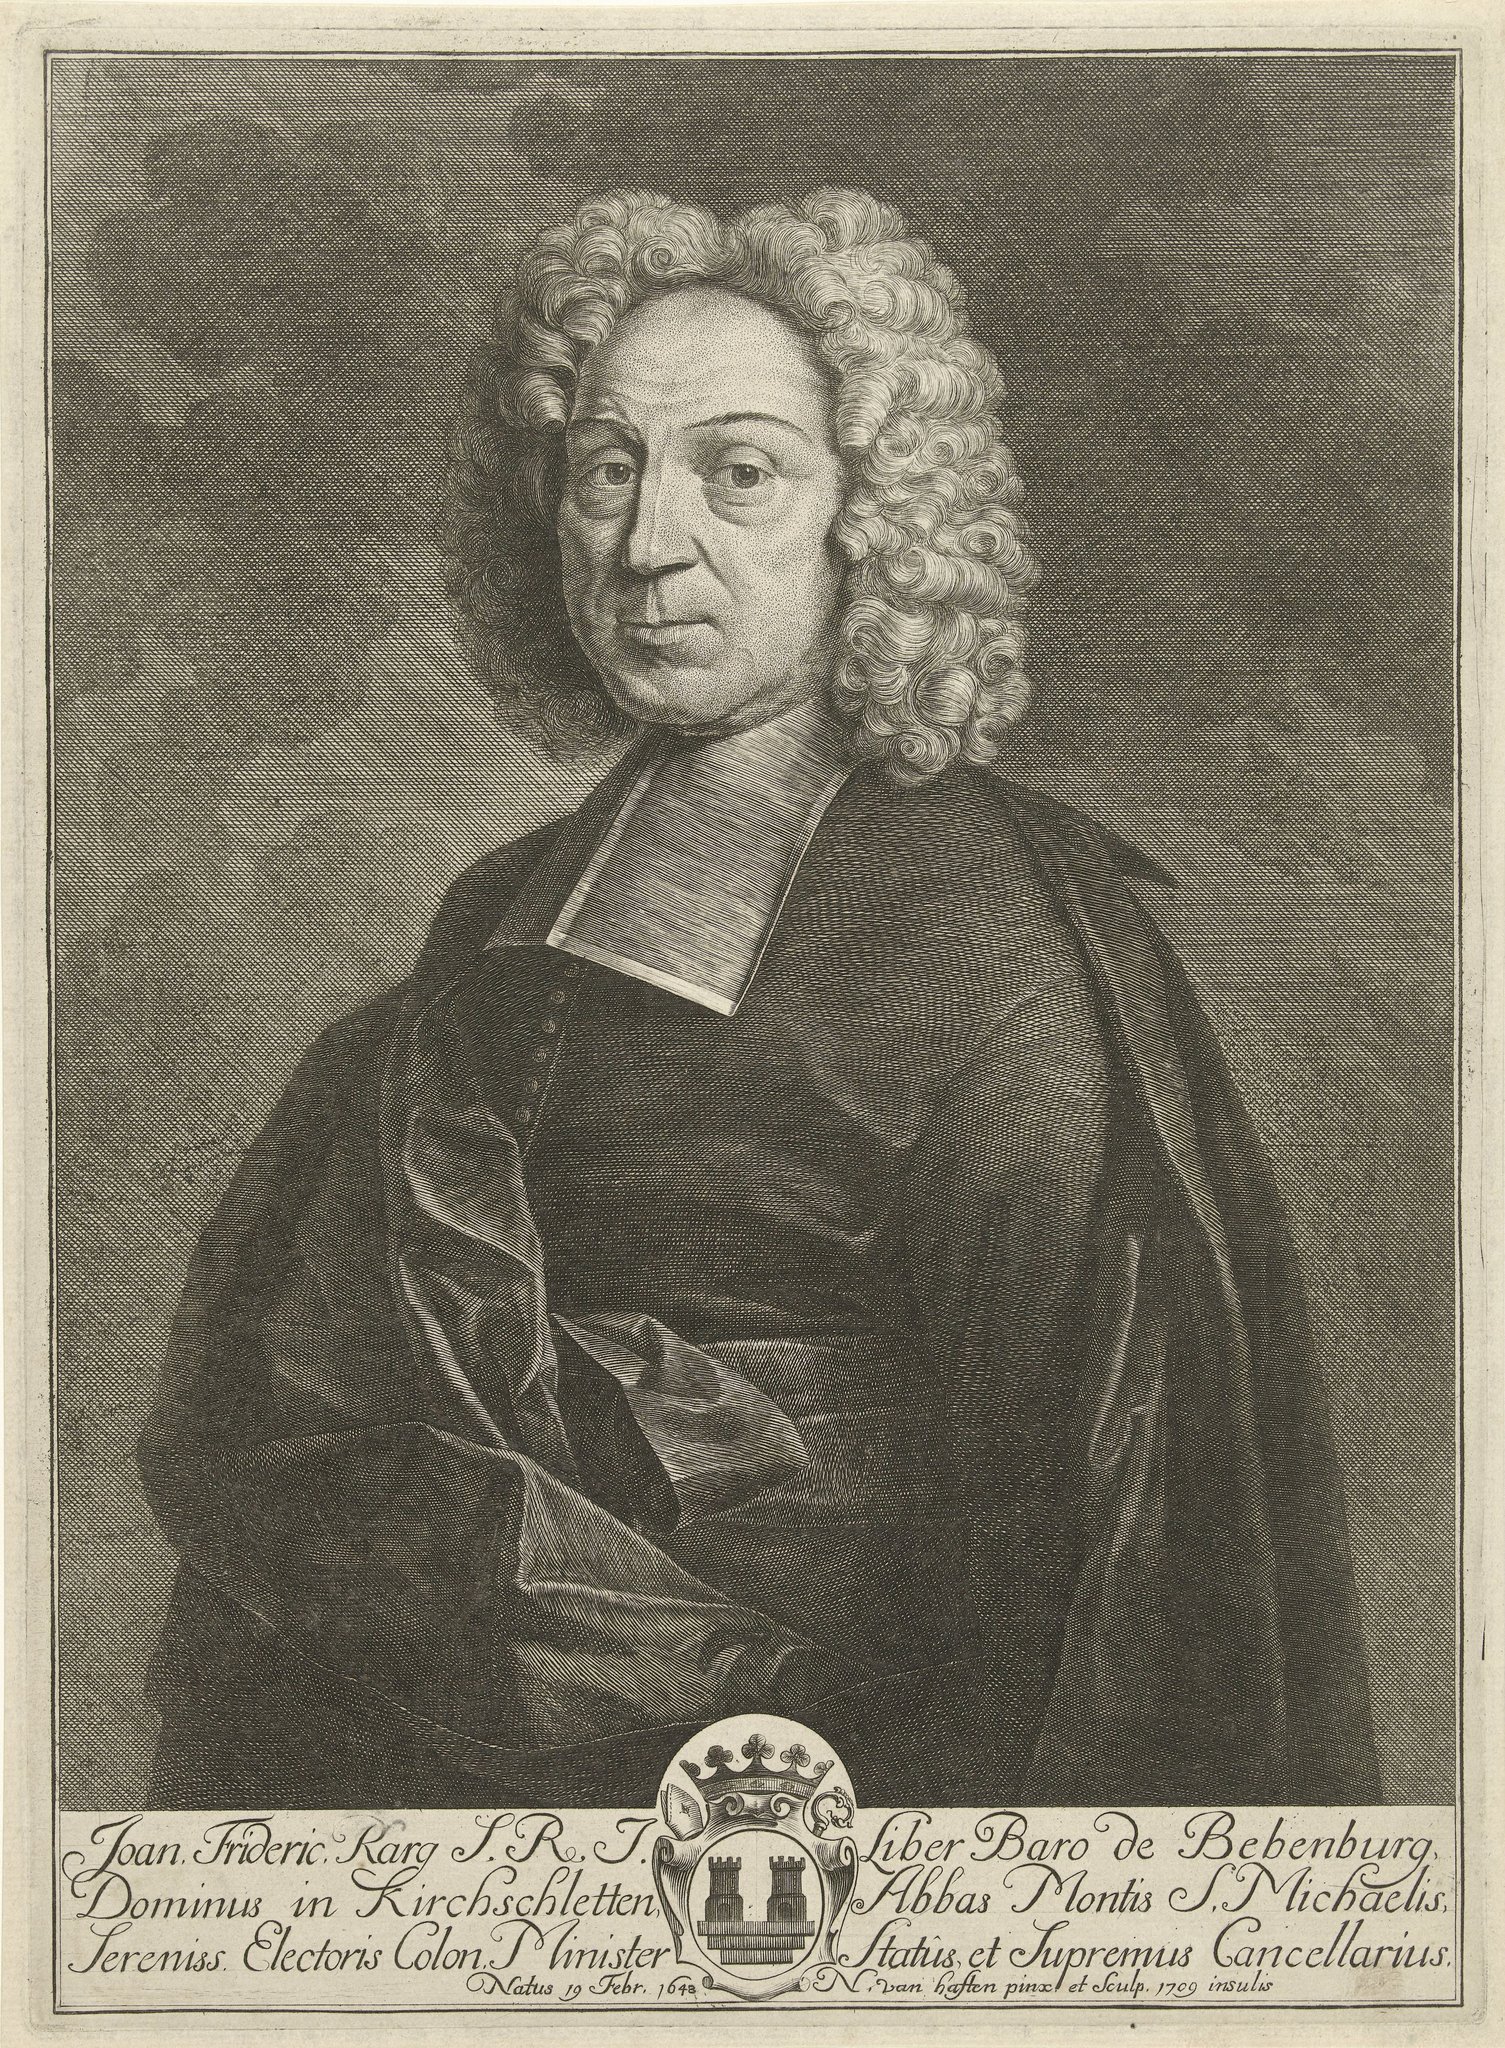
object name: print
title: Portret van Johann Friedrich Karg, baron van Bebenburg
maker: nicolaes van haeften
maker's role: draughtsman, painter, print maker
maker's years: 1653-1715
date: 1709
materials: paper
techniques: engraving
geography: paris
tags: johann friedrich reichsfreiherr karg von bebenburg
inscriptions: collector's mark: Lugt 2228, collector's mark: Lugt 1209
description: Portret van Johann Friederich Karg, baron van Bebenburg op 61-jarige leeftijd, ten halven lijve, met pruik en zwart gewaad met witte kraag tegen een achtergrond van wolken, onder een drieregelige tekst in Latijn met zijn familiewapen.